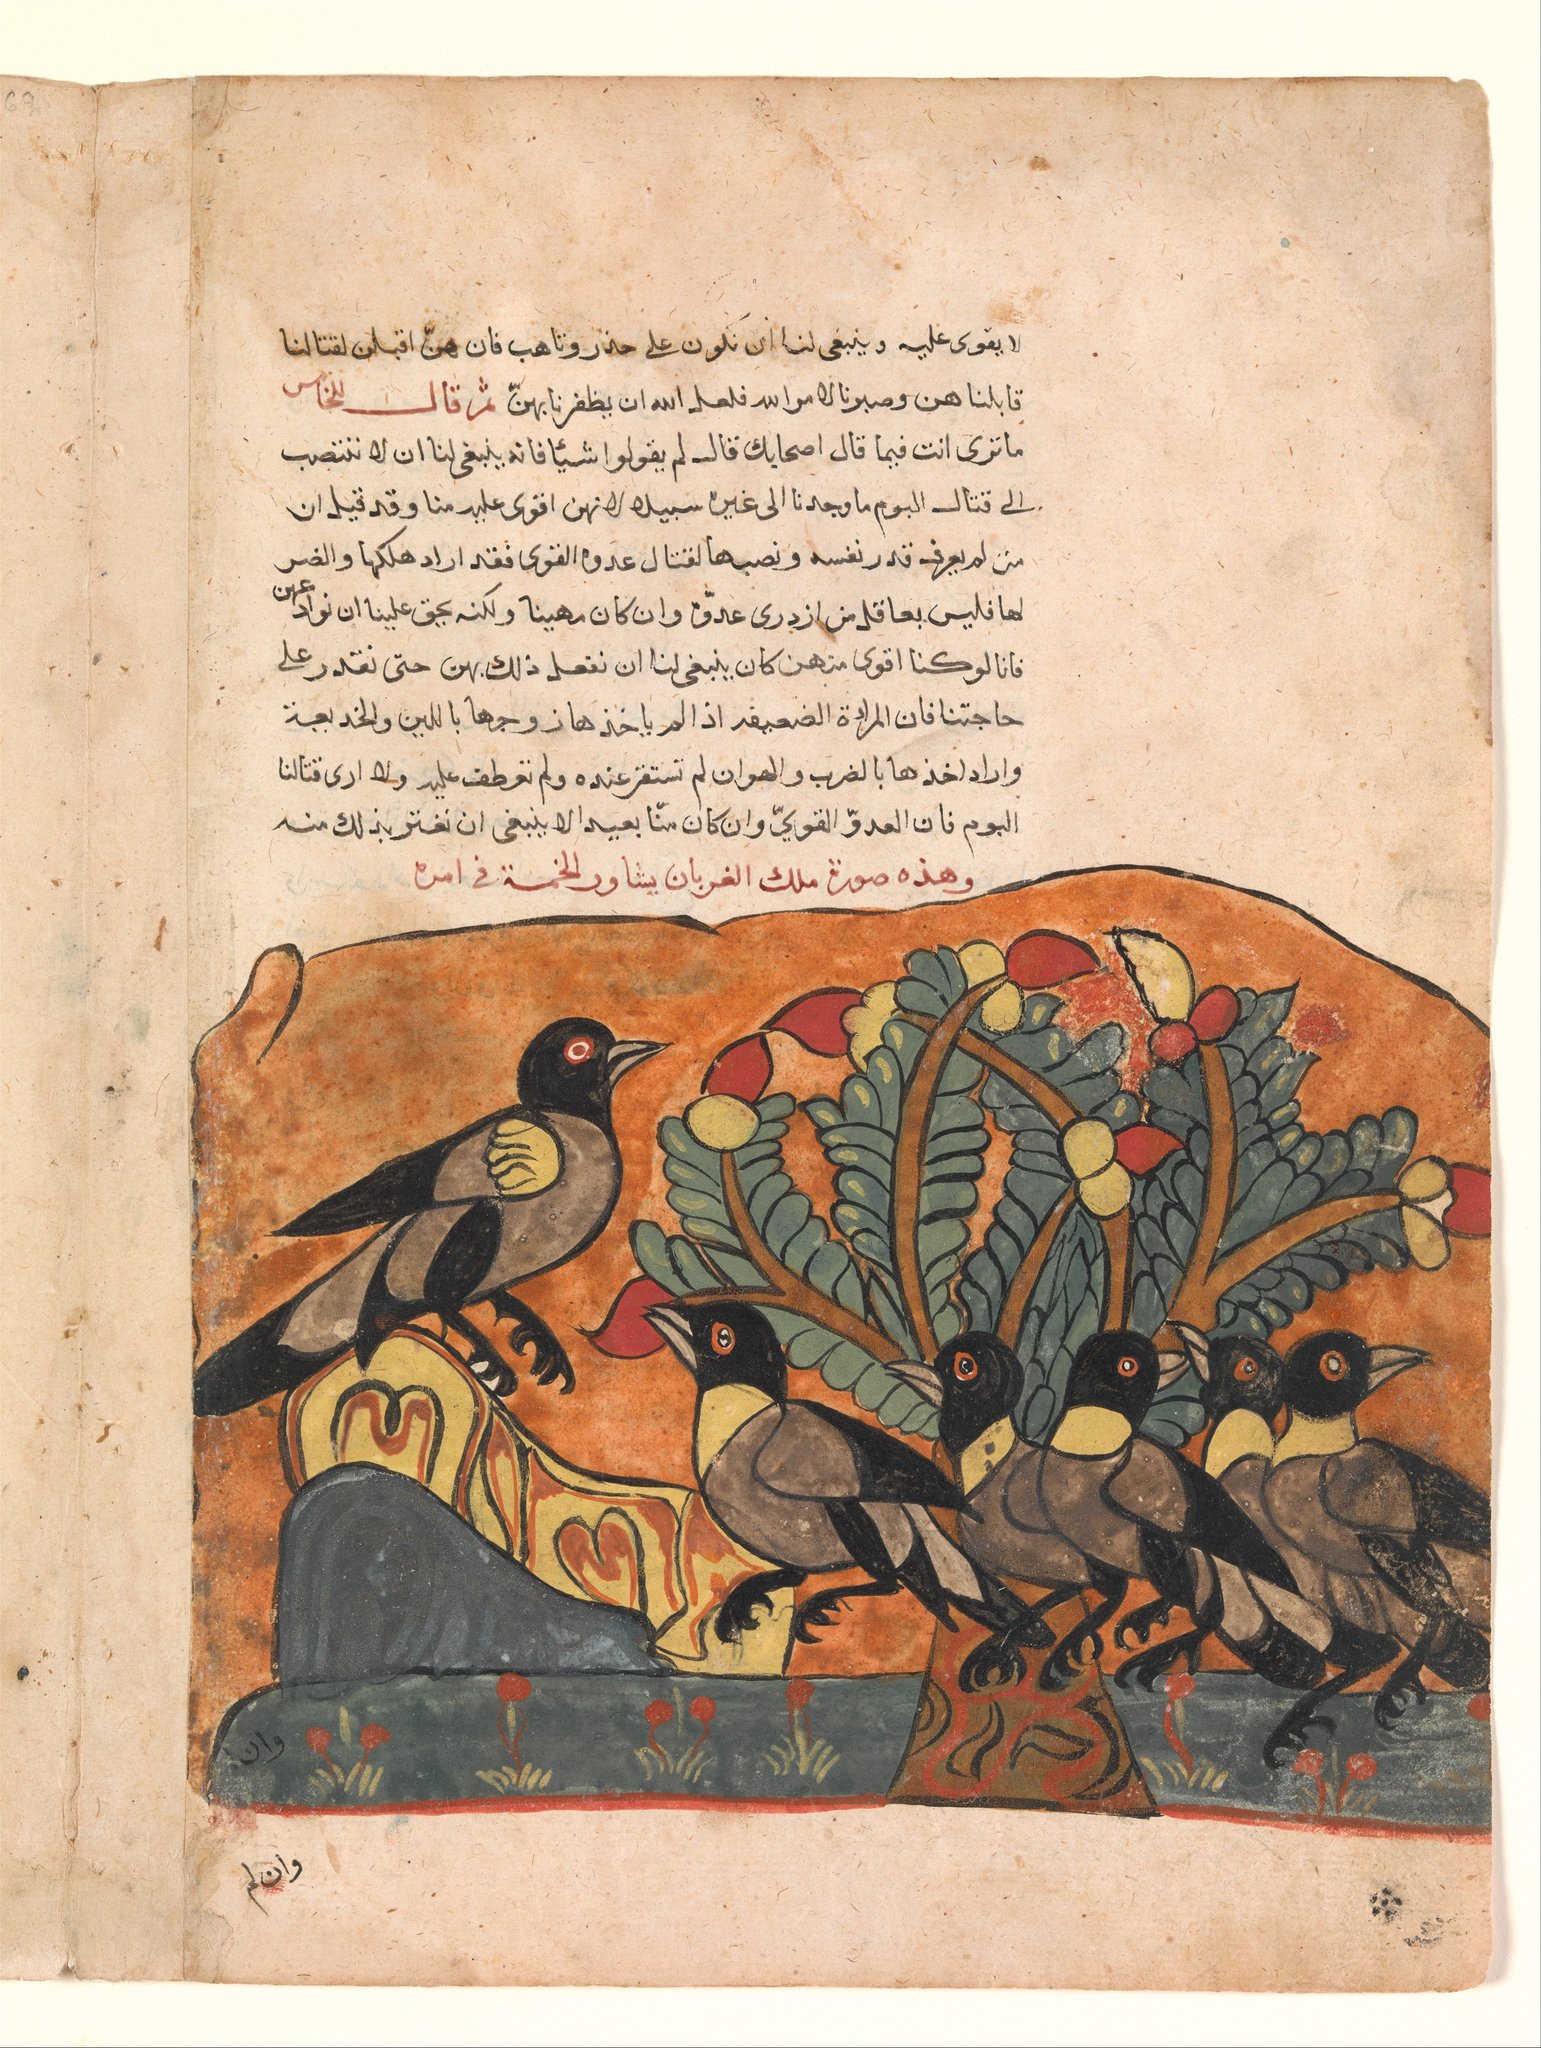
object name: folio from an illustrated manuscript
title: "The Crow King Consults his Ministers", Folio from a Kalila wa Dimna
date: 1526-1550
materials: ink, paper, watercolor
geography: india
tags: birds